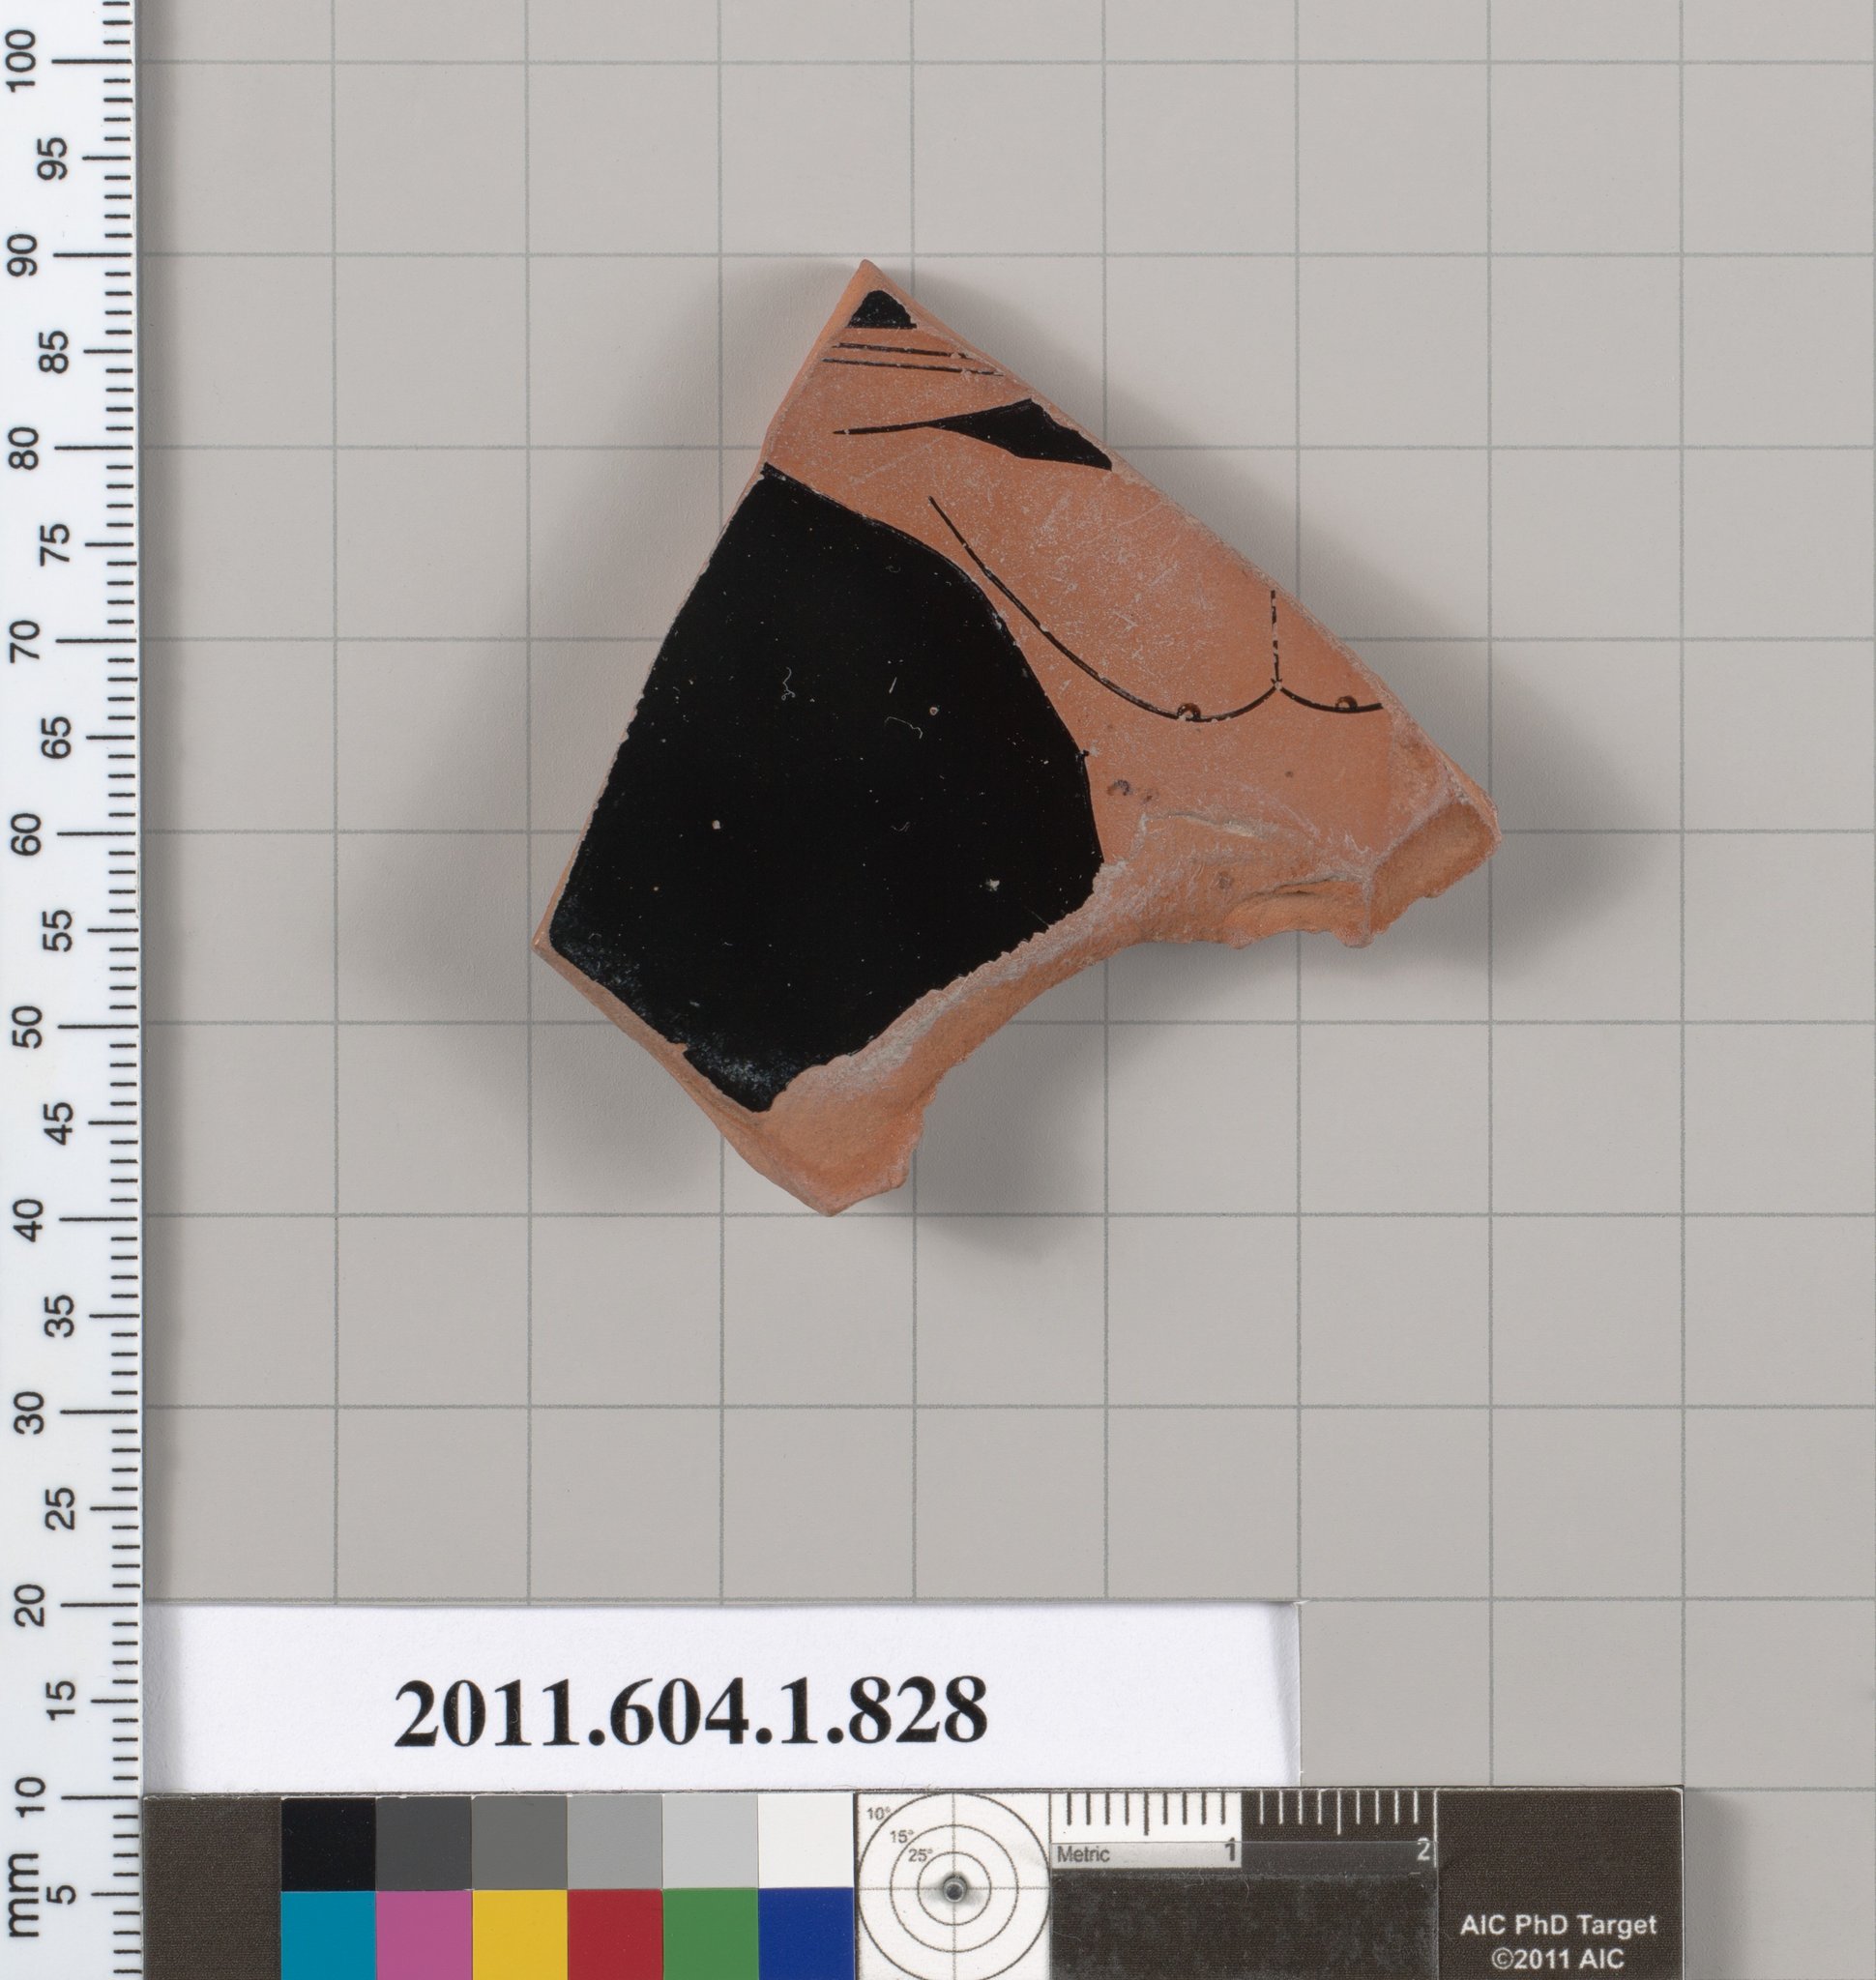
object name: kylix fragment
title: Terracotta fragment of a kylix (drinking cup)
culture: greek, attic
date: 475-451 BCE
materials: terracotta